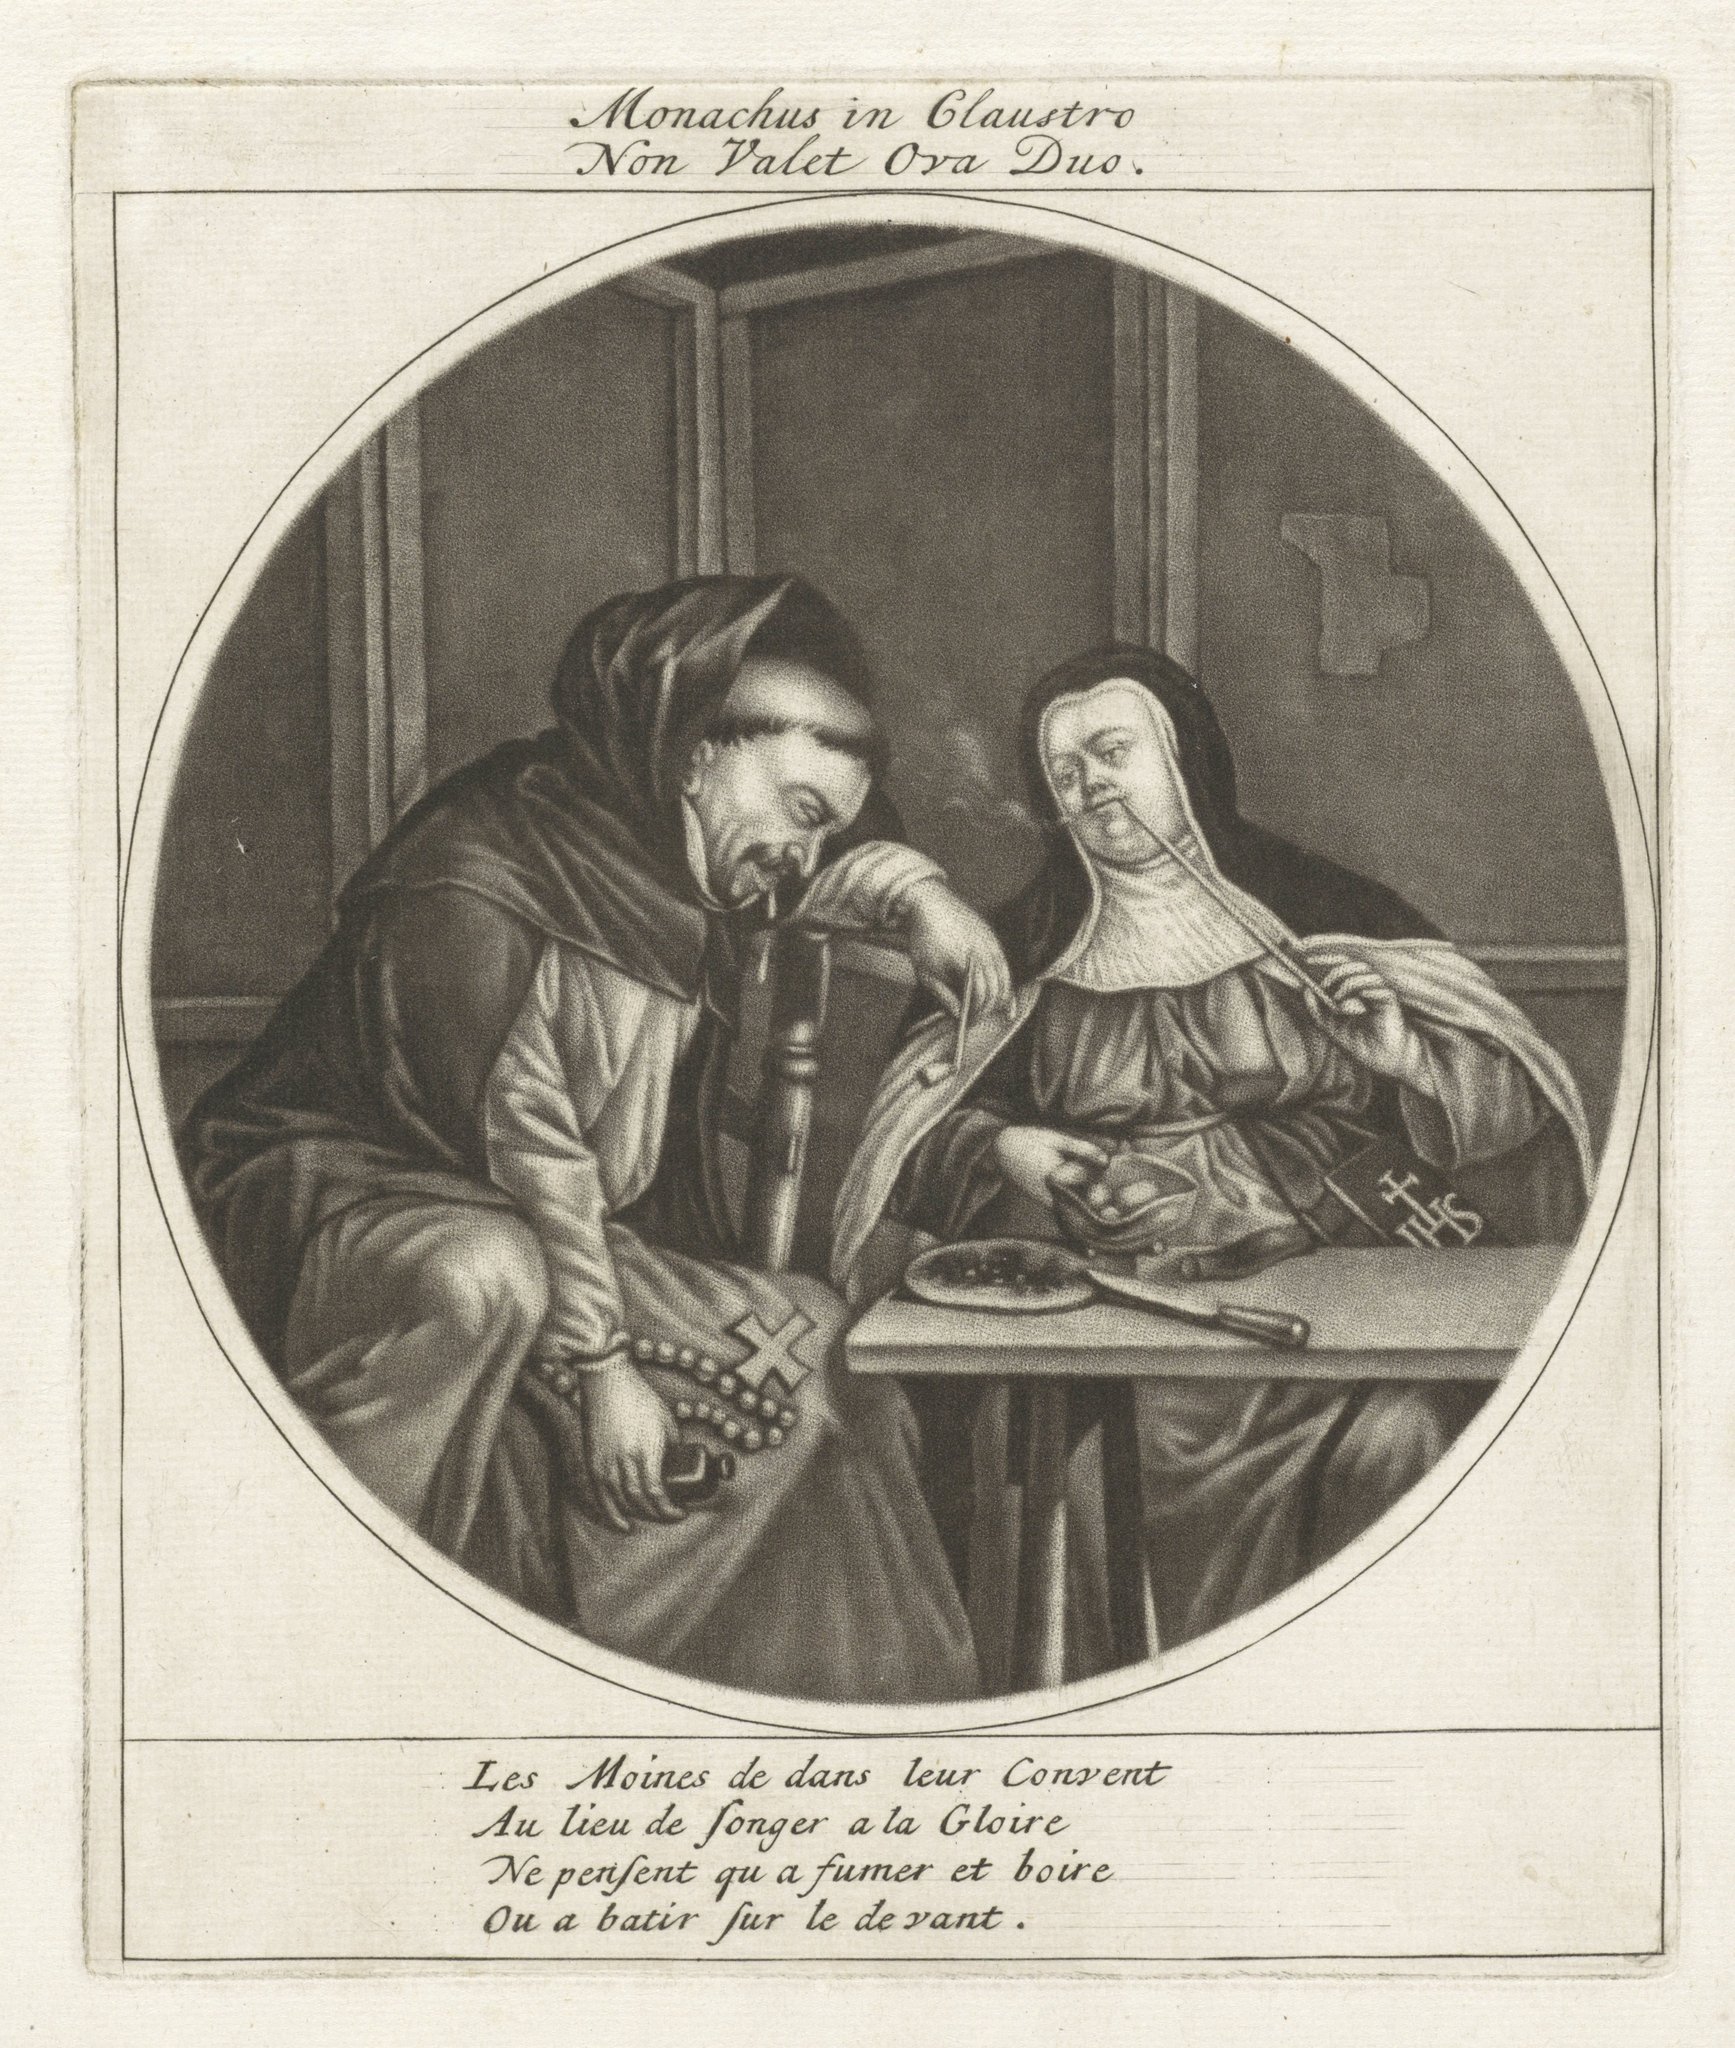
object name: print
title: Monachus in Glaustro / Non Valet Ova Duo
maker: cornelis dusart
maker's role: draughtsman, painter, print maker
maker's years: 1660-1704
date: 1670-1704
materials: paper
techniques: engraving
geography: haarlem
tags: monks and nuns, pipe ~ tobacco, monk(s), friar(s), drunkenness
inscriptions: collector's mark: Lugt 2228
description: Een dronken monnik en een pijprokende non zitten aan een tafel. De prent maakt deel uit van een serie van zes prenten met monniken en nonnen.